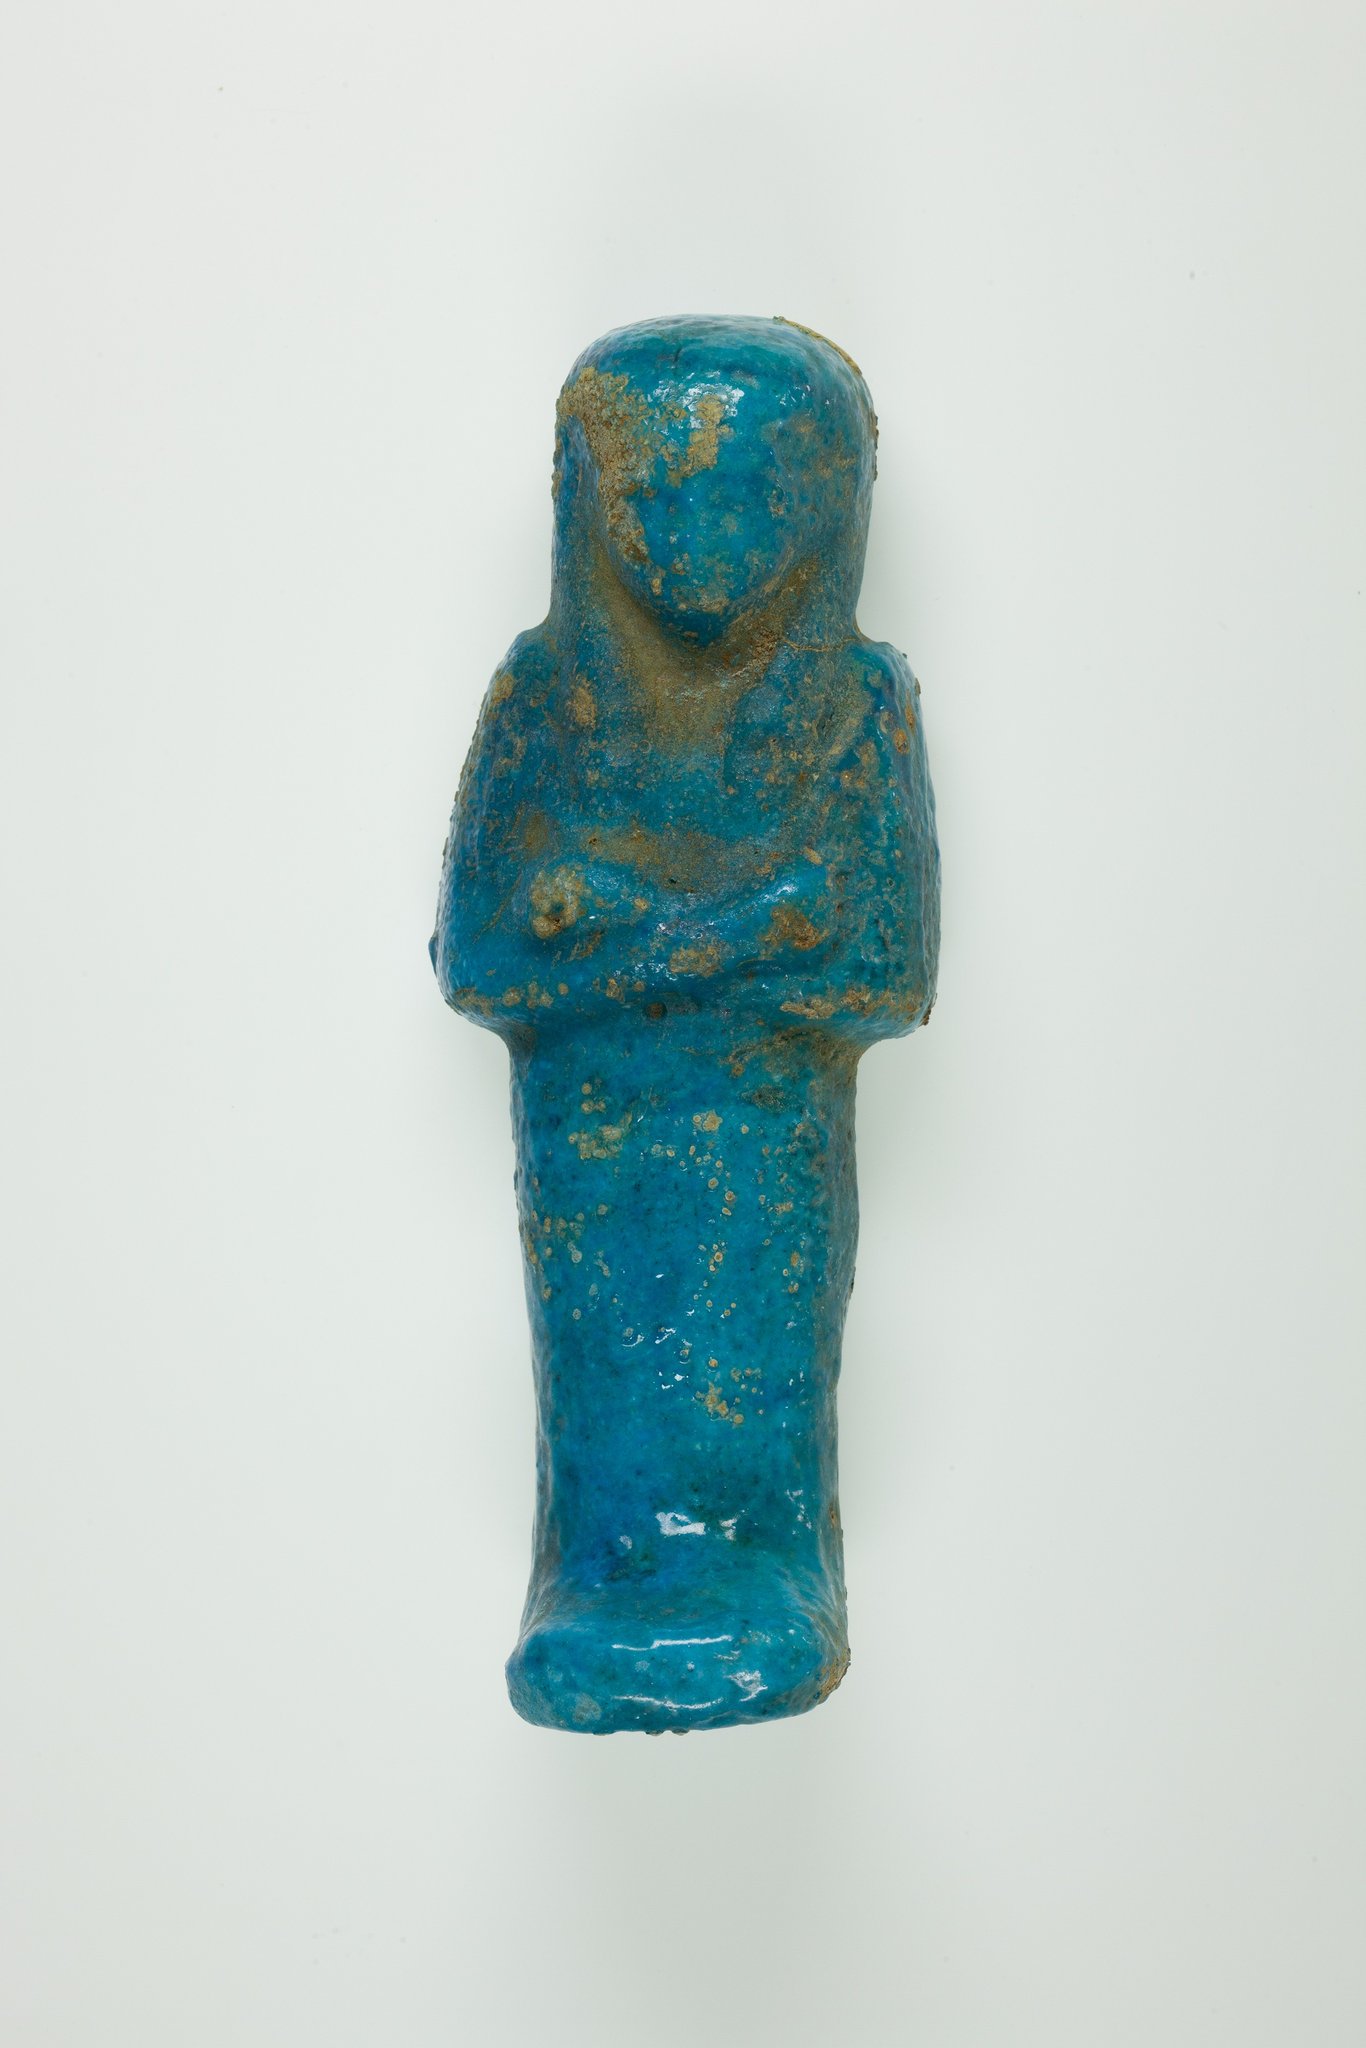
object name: worker shabti, henettawy c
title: Worker Shabti of Henettawy (C), Daughter of Isetemkheb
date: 990-970 BCE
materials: faience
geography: egypt